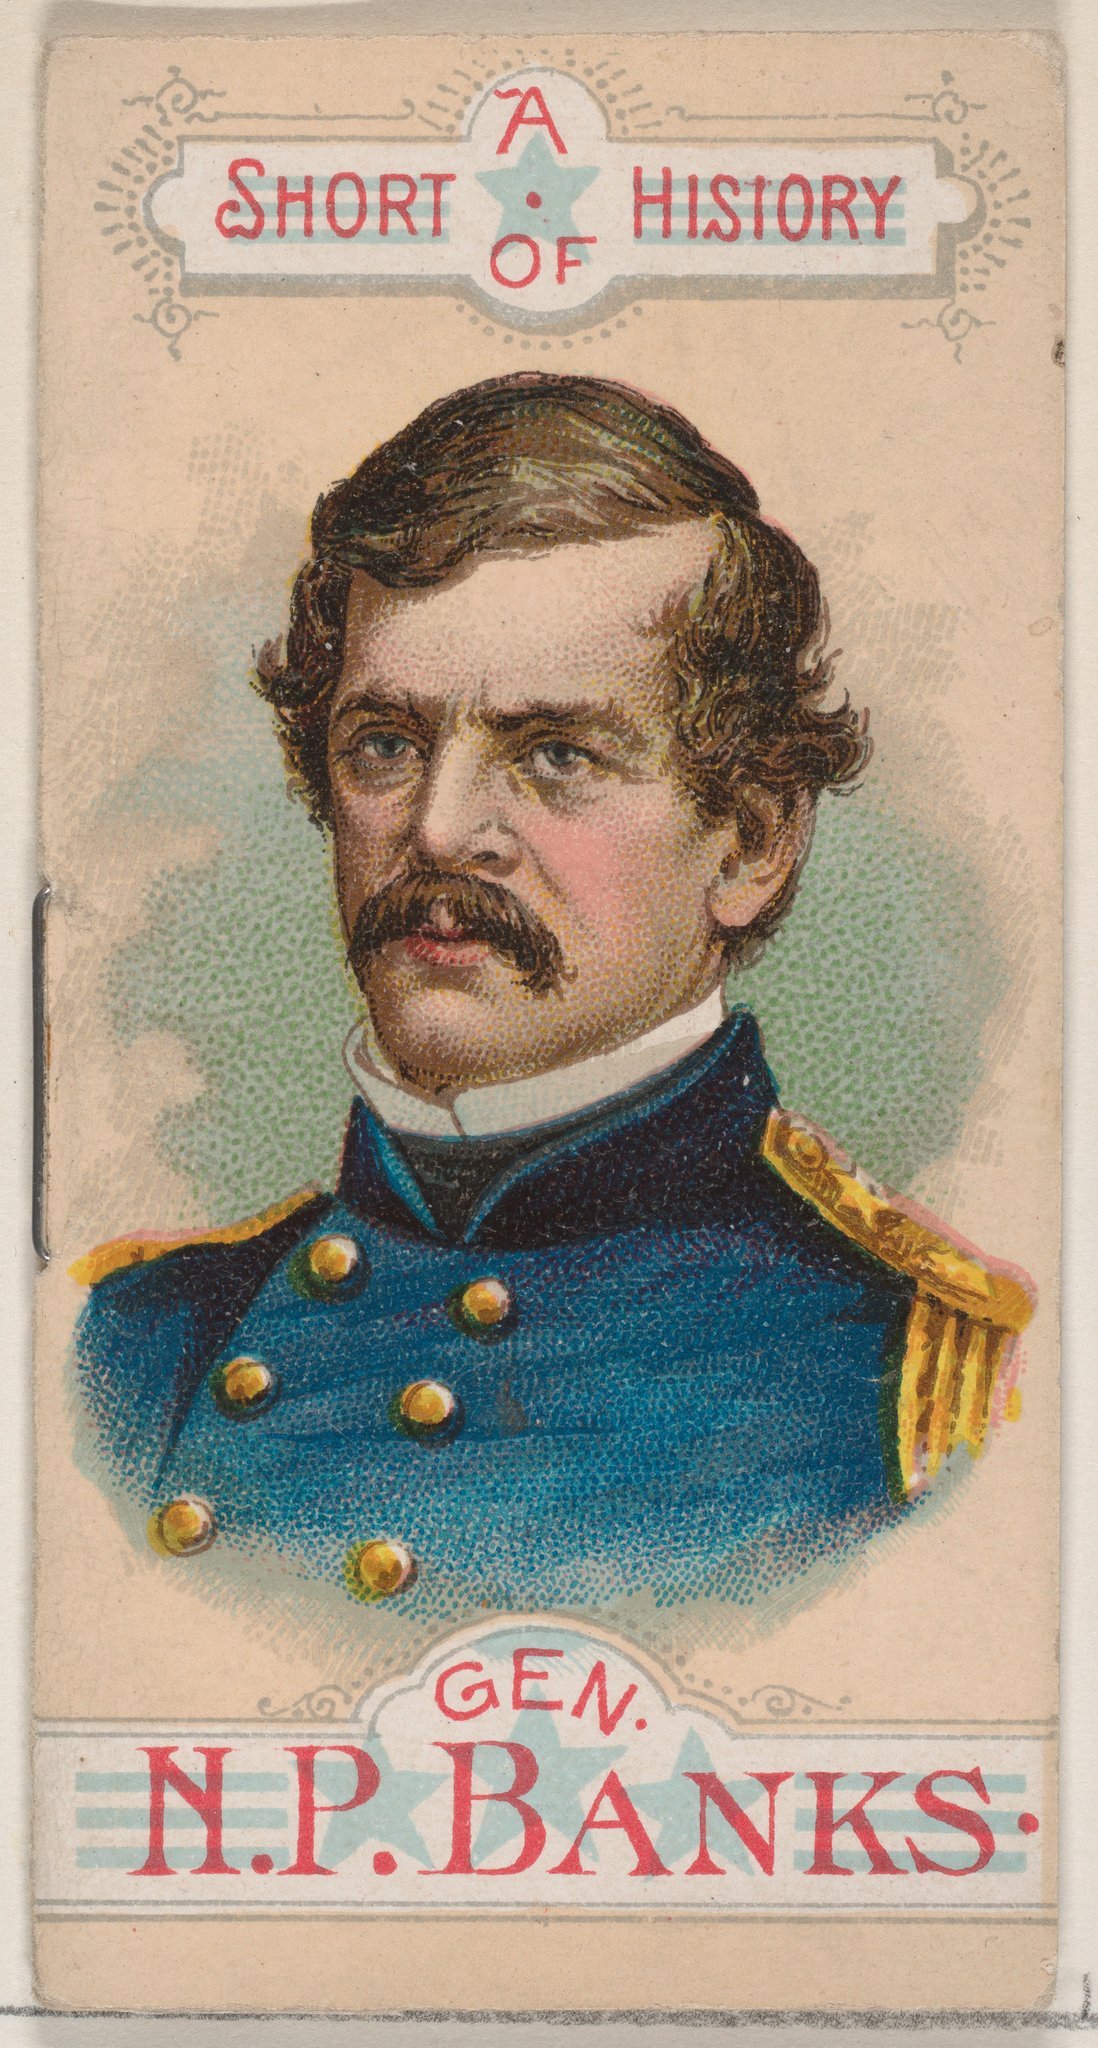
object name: print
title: A Short History of General Nathaniel Prentiss Banks, from the Histories of Generals series of booklets (N78) for Duke brand cigarettes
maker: w. duke, sons & co.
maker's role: publisher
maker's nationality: american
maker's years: 1870-1920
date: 1888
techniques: color lithograph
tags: men